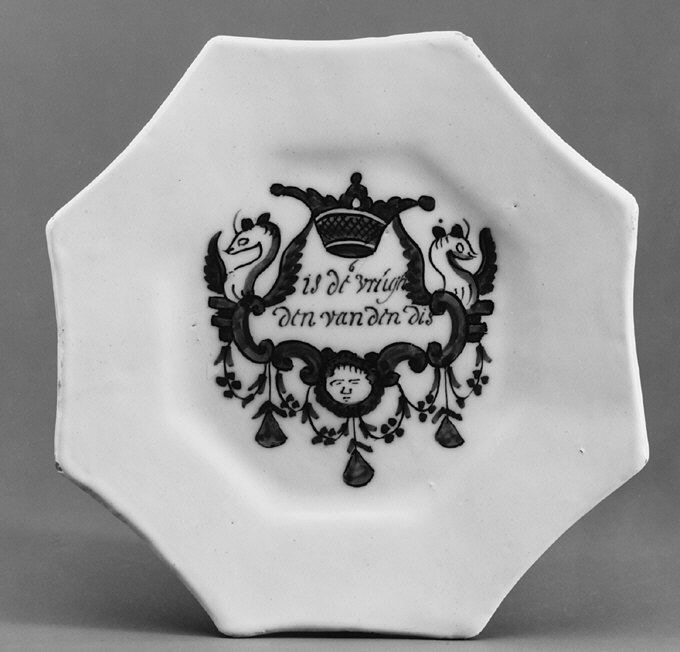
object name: plate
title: Plate (part of a set)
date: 1660-1690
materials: earthenware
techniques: glazing